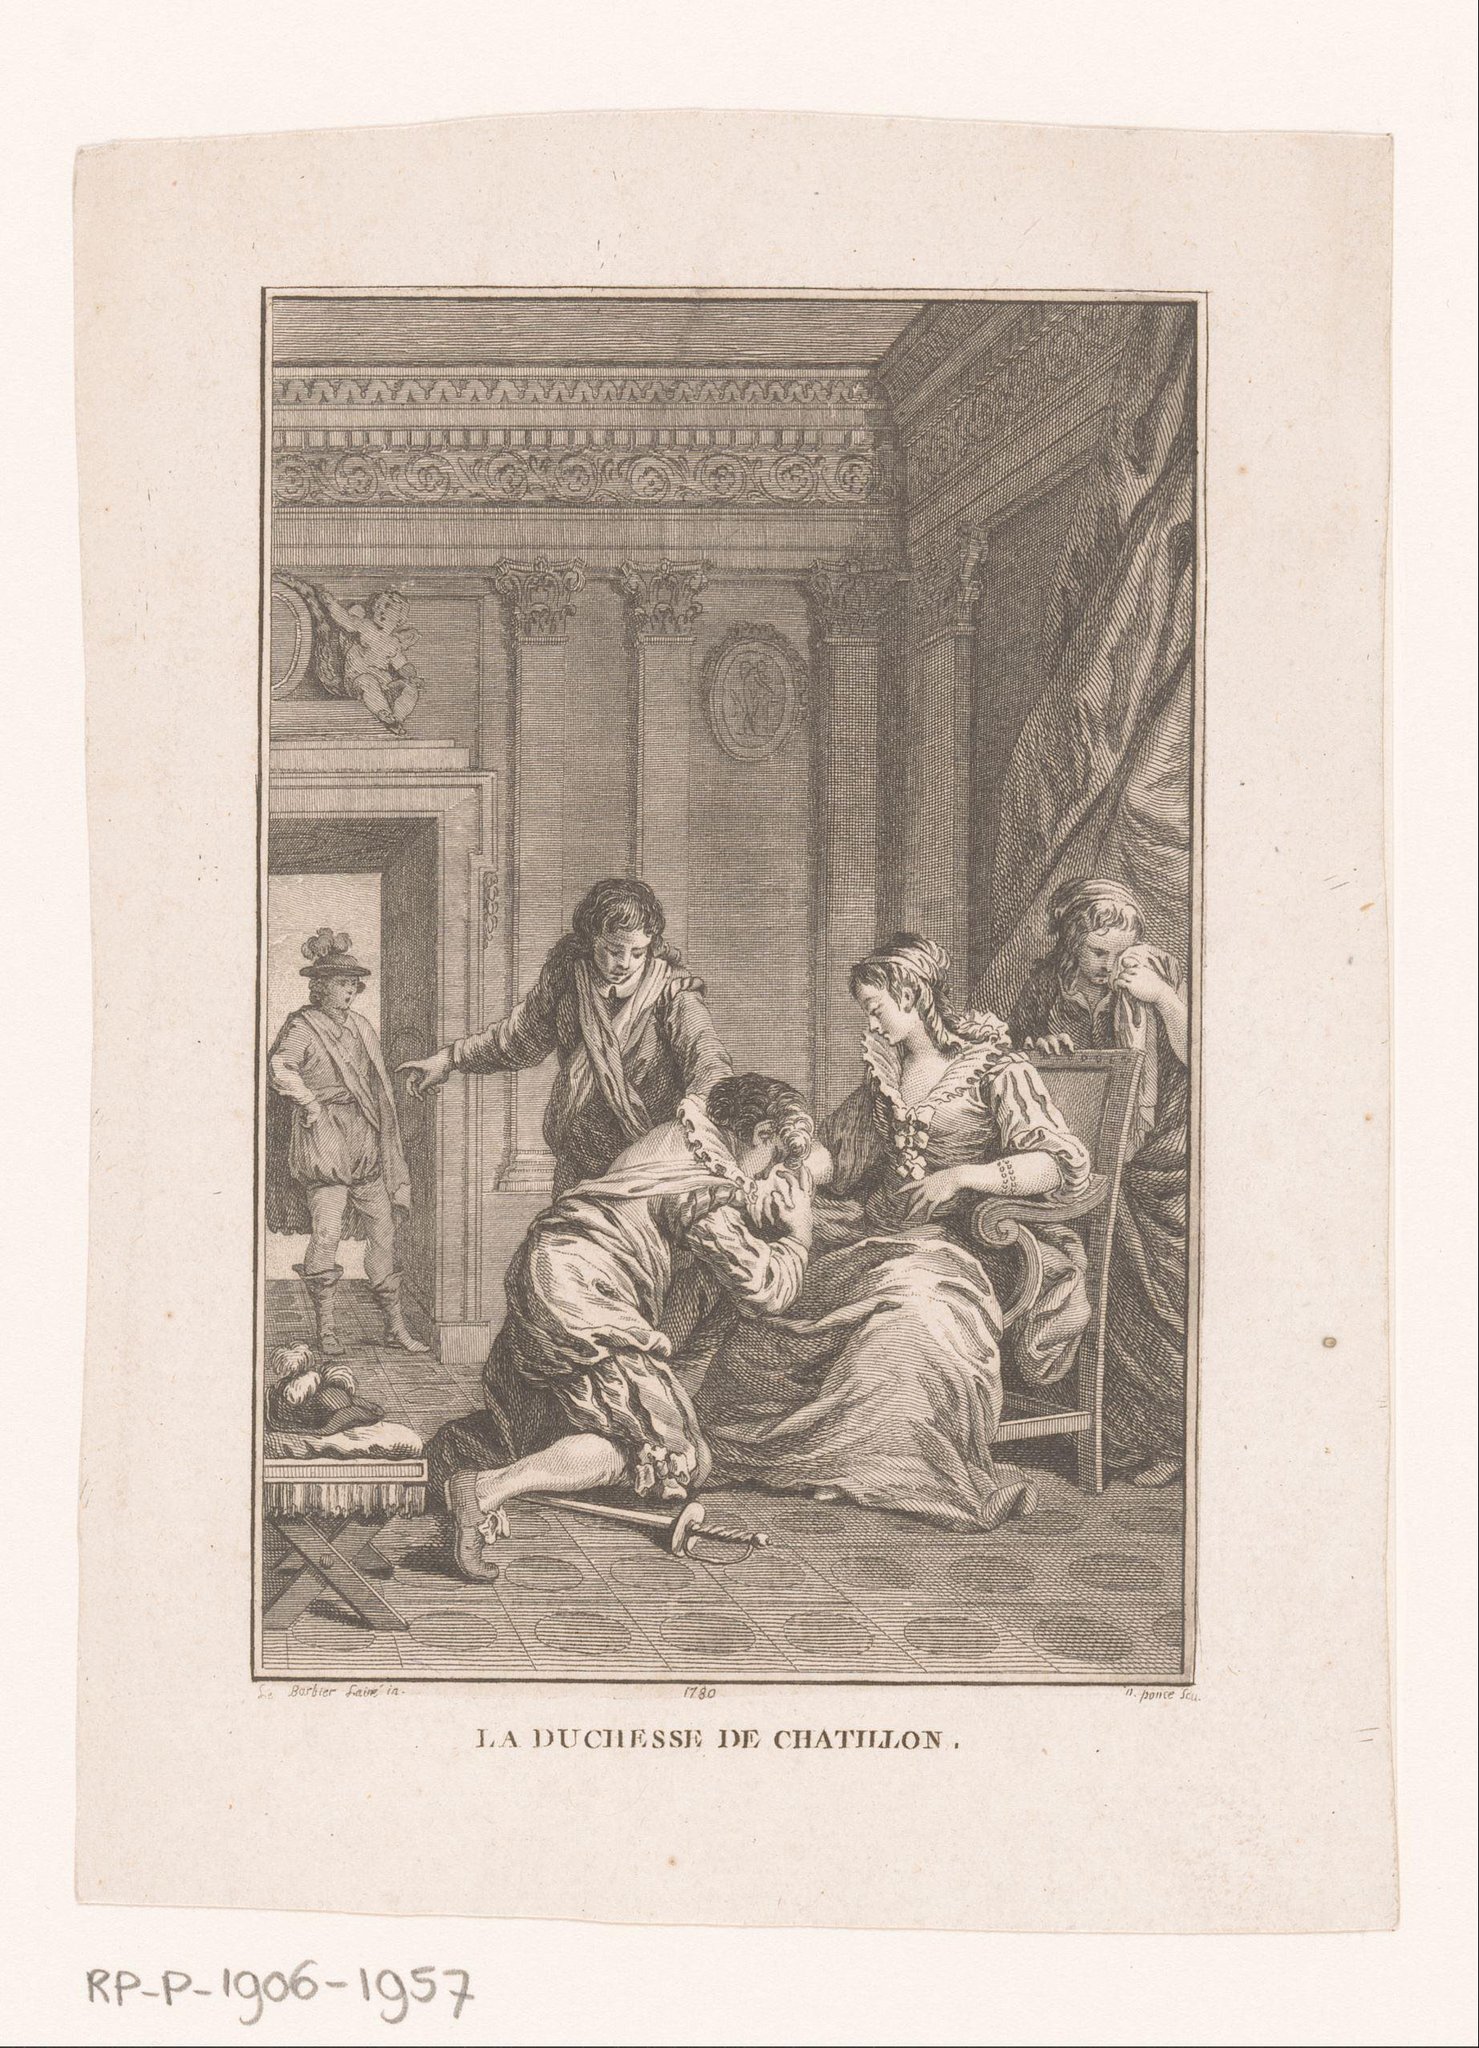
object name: print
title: La duchesse de Chatillon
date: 1780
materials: paper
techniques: engraving, etching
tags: paris, nobility and patriciate; chivalry, knighthood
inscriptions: collector's mark: Lugt 2228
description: Betreft mogelijk Élisabeth-Angélique de Montmorency-Bouteville.